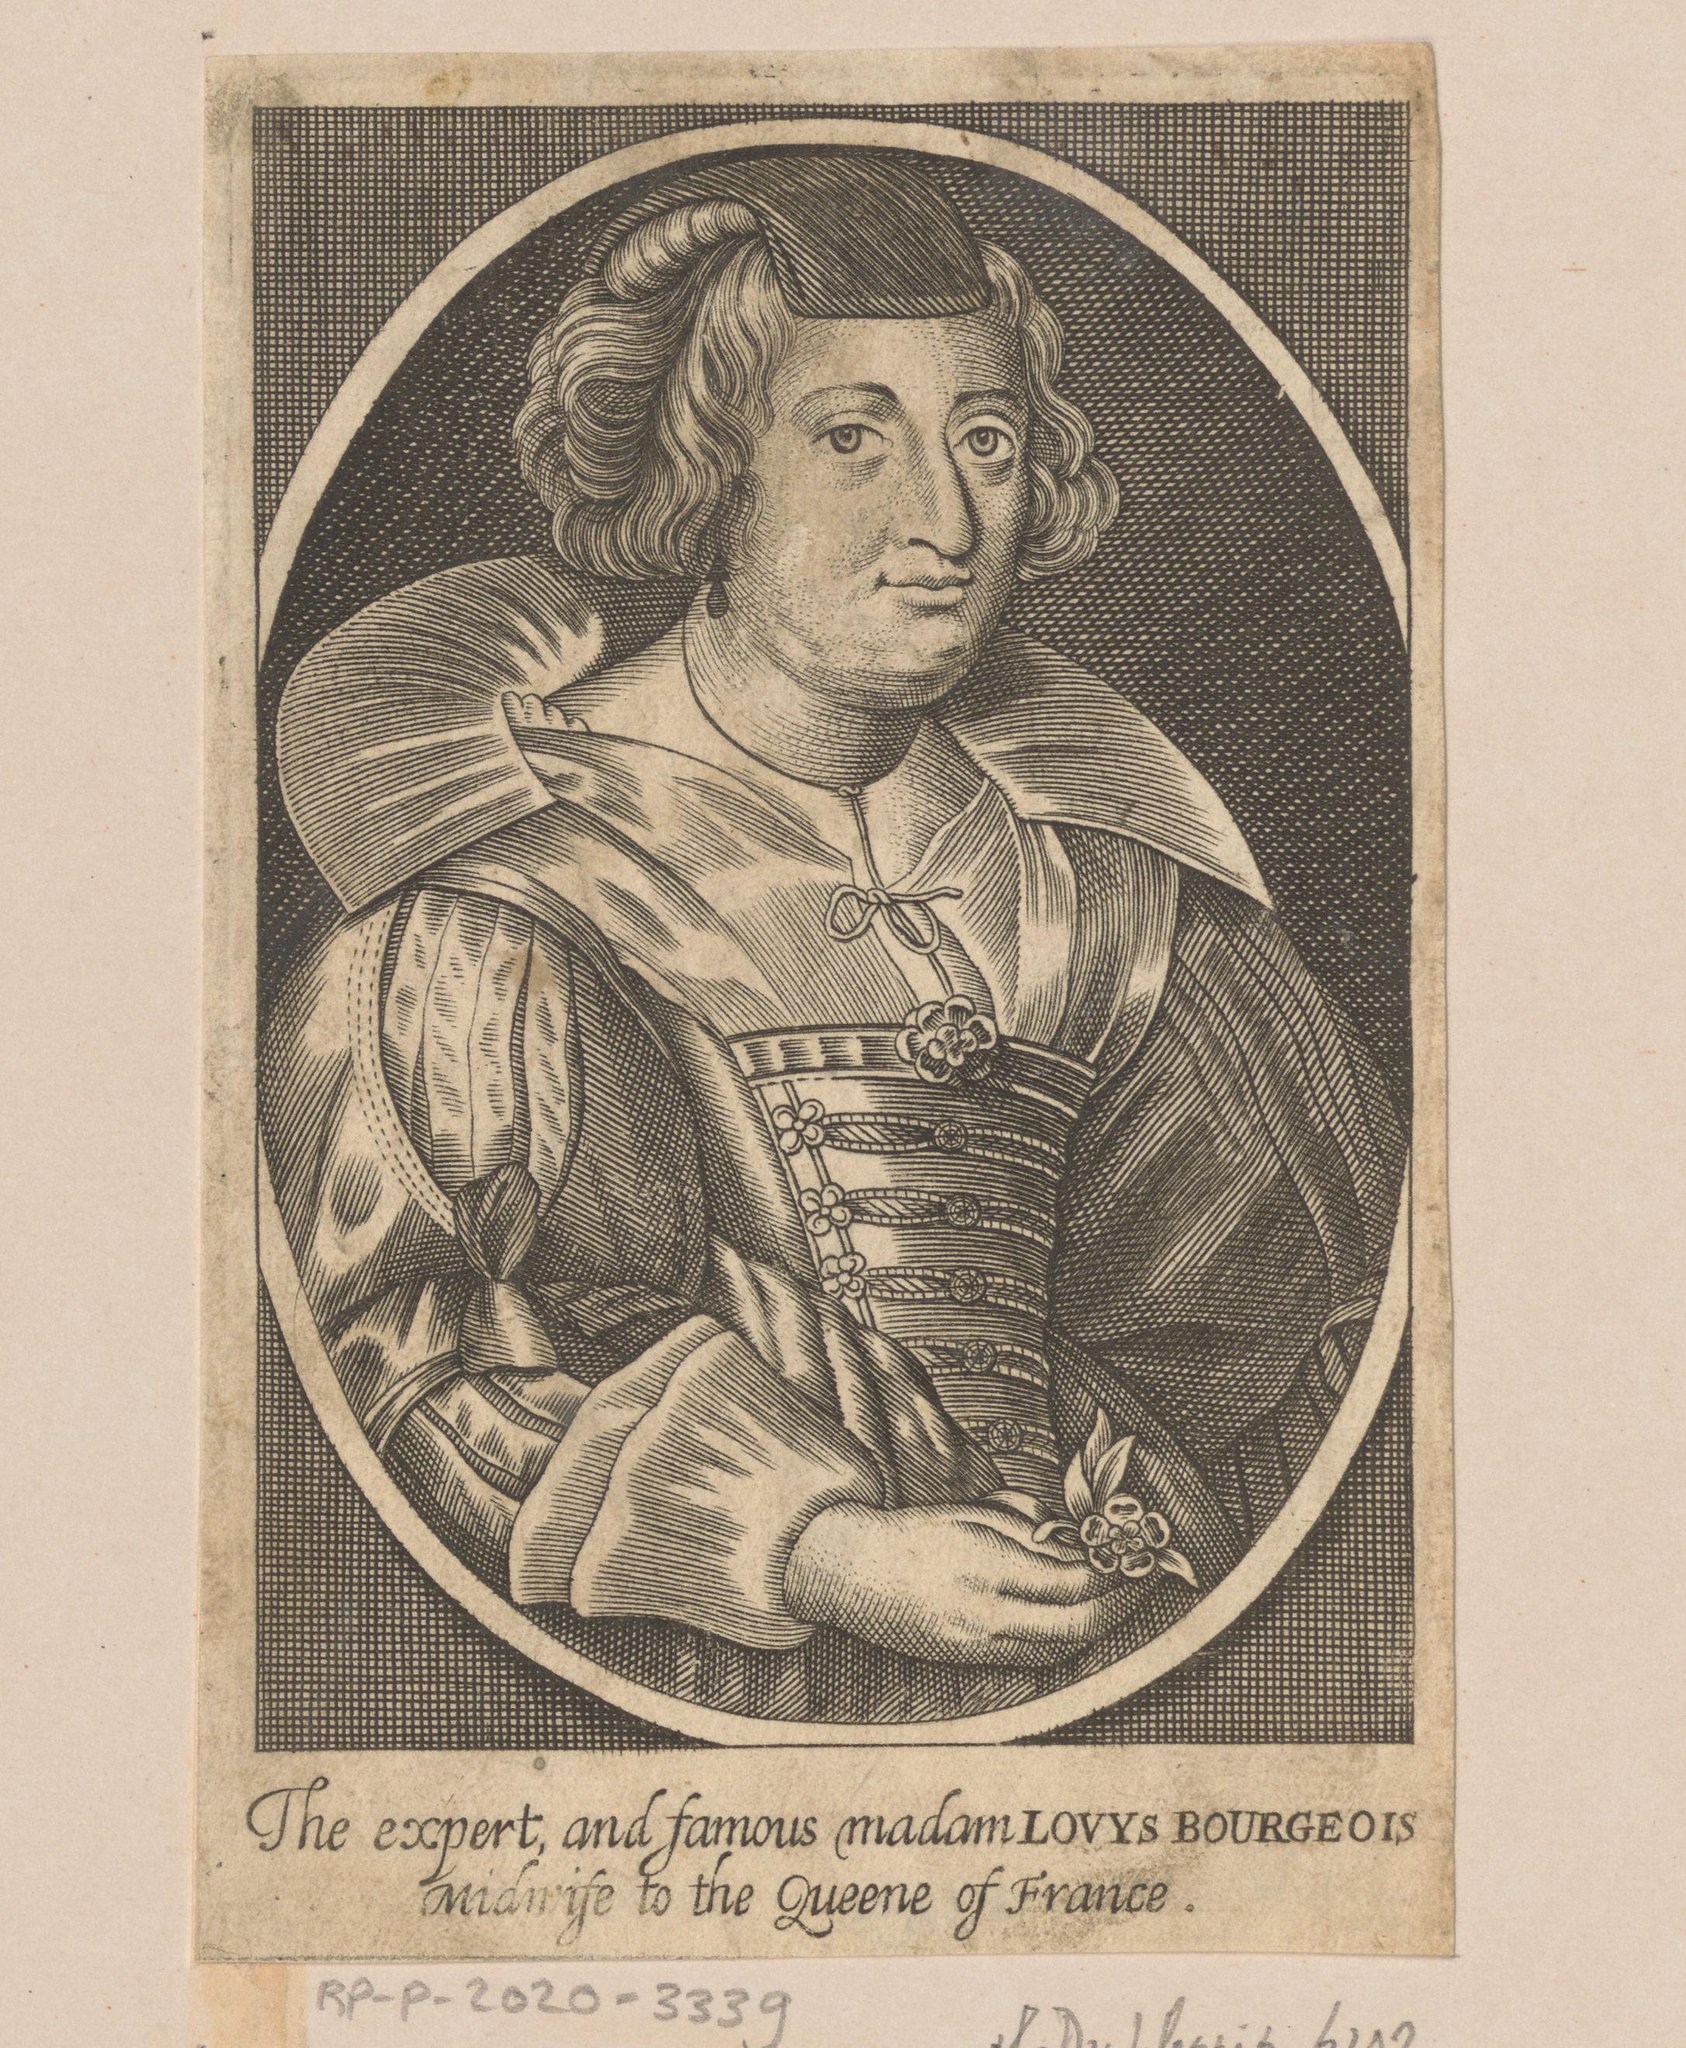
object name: print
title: Portret van Louise Bourgeois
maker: Anonymous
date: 1650-1699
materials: paper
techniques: engraving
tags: historical persons - bb - woman, midwife, 'accoucheuse'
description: Prent gebruikt in: The Compleat Midwife's Practice Enlarged (...). Londen: R. Bentley, 1697. Prent mogelijk ook gebruikt in eerdere edities van dit werk.